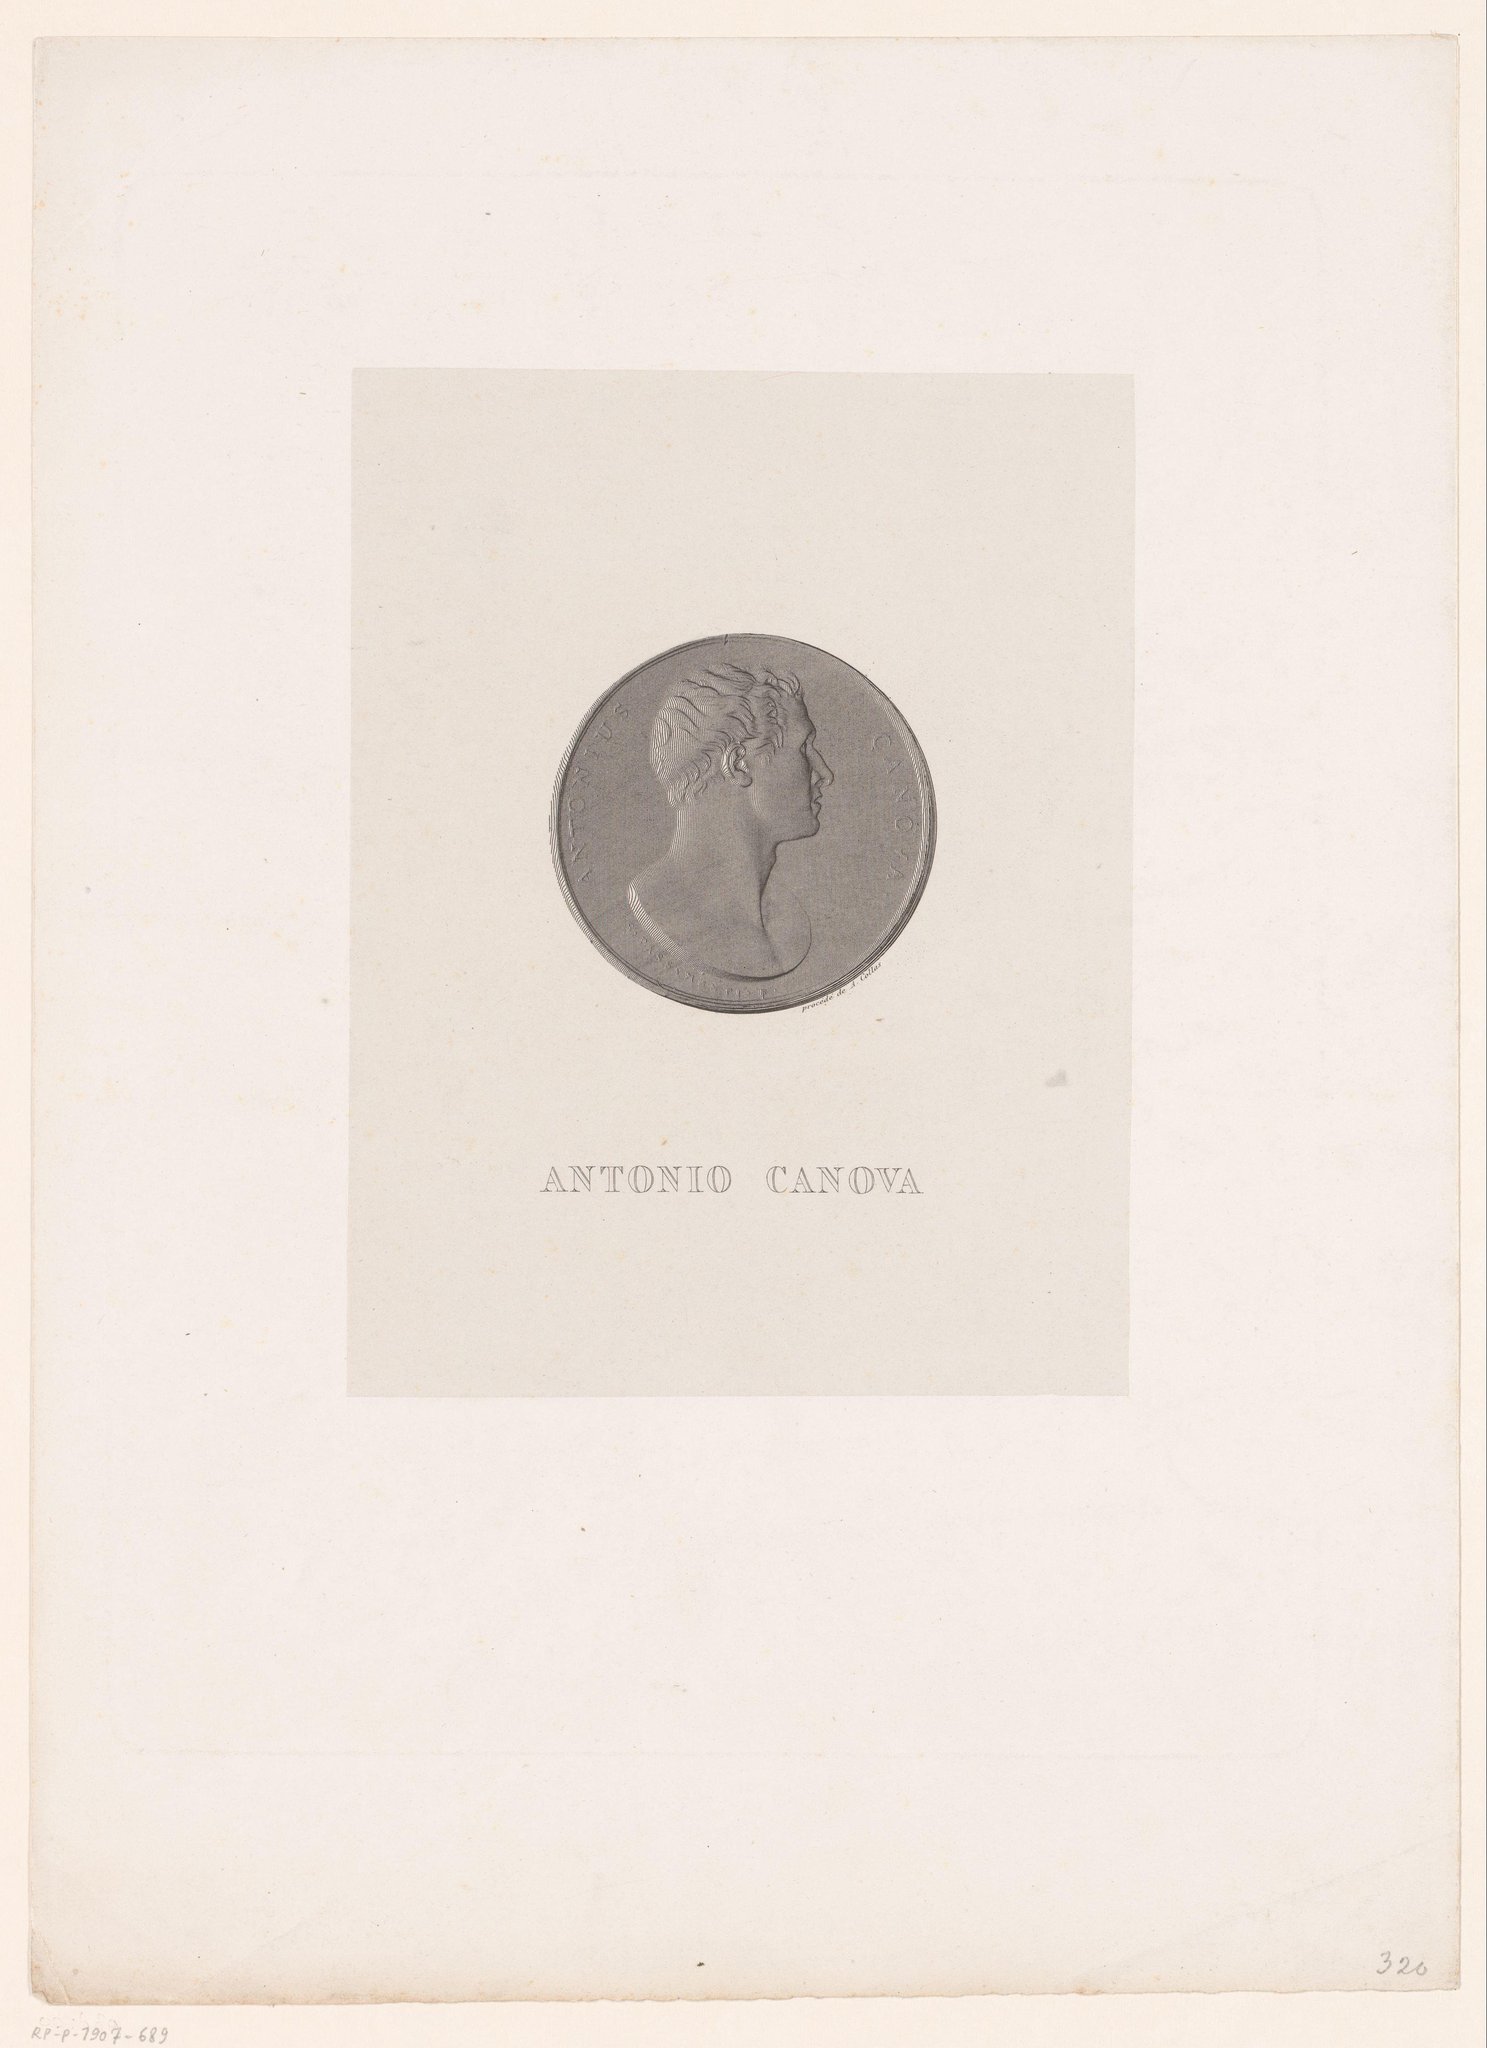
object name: print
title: Medaillon met portret van Antonio Canova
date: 1804-1859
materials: paper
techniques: relief engraving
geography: france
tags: venice, painter, draughtsman, sculptor, antonio canova, ornament ~ medallion, historical persons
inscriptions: collector's mark: Lugt 2228